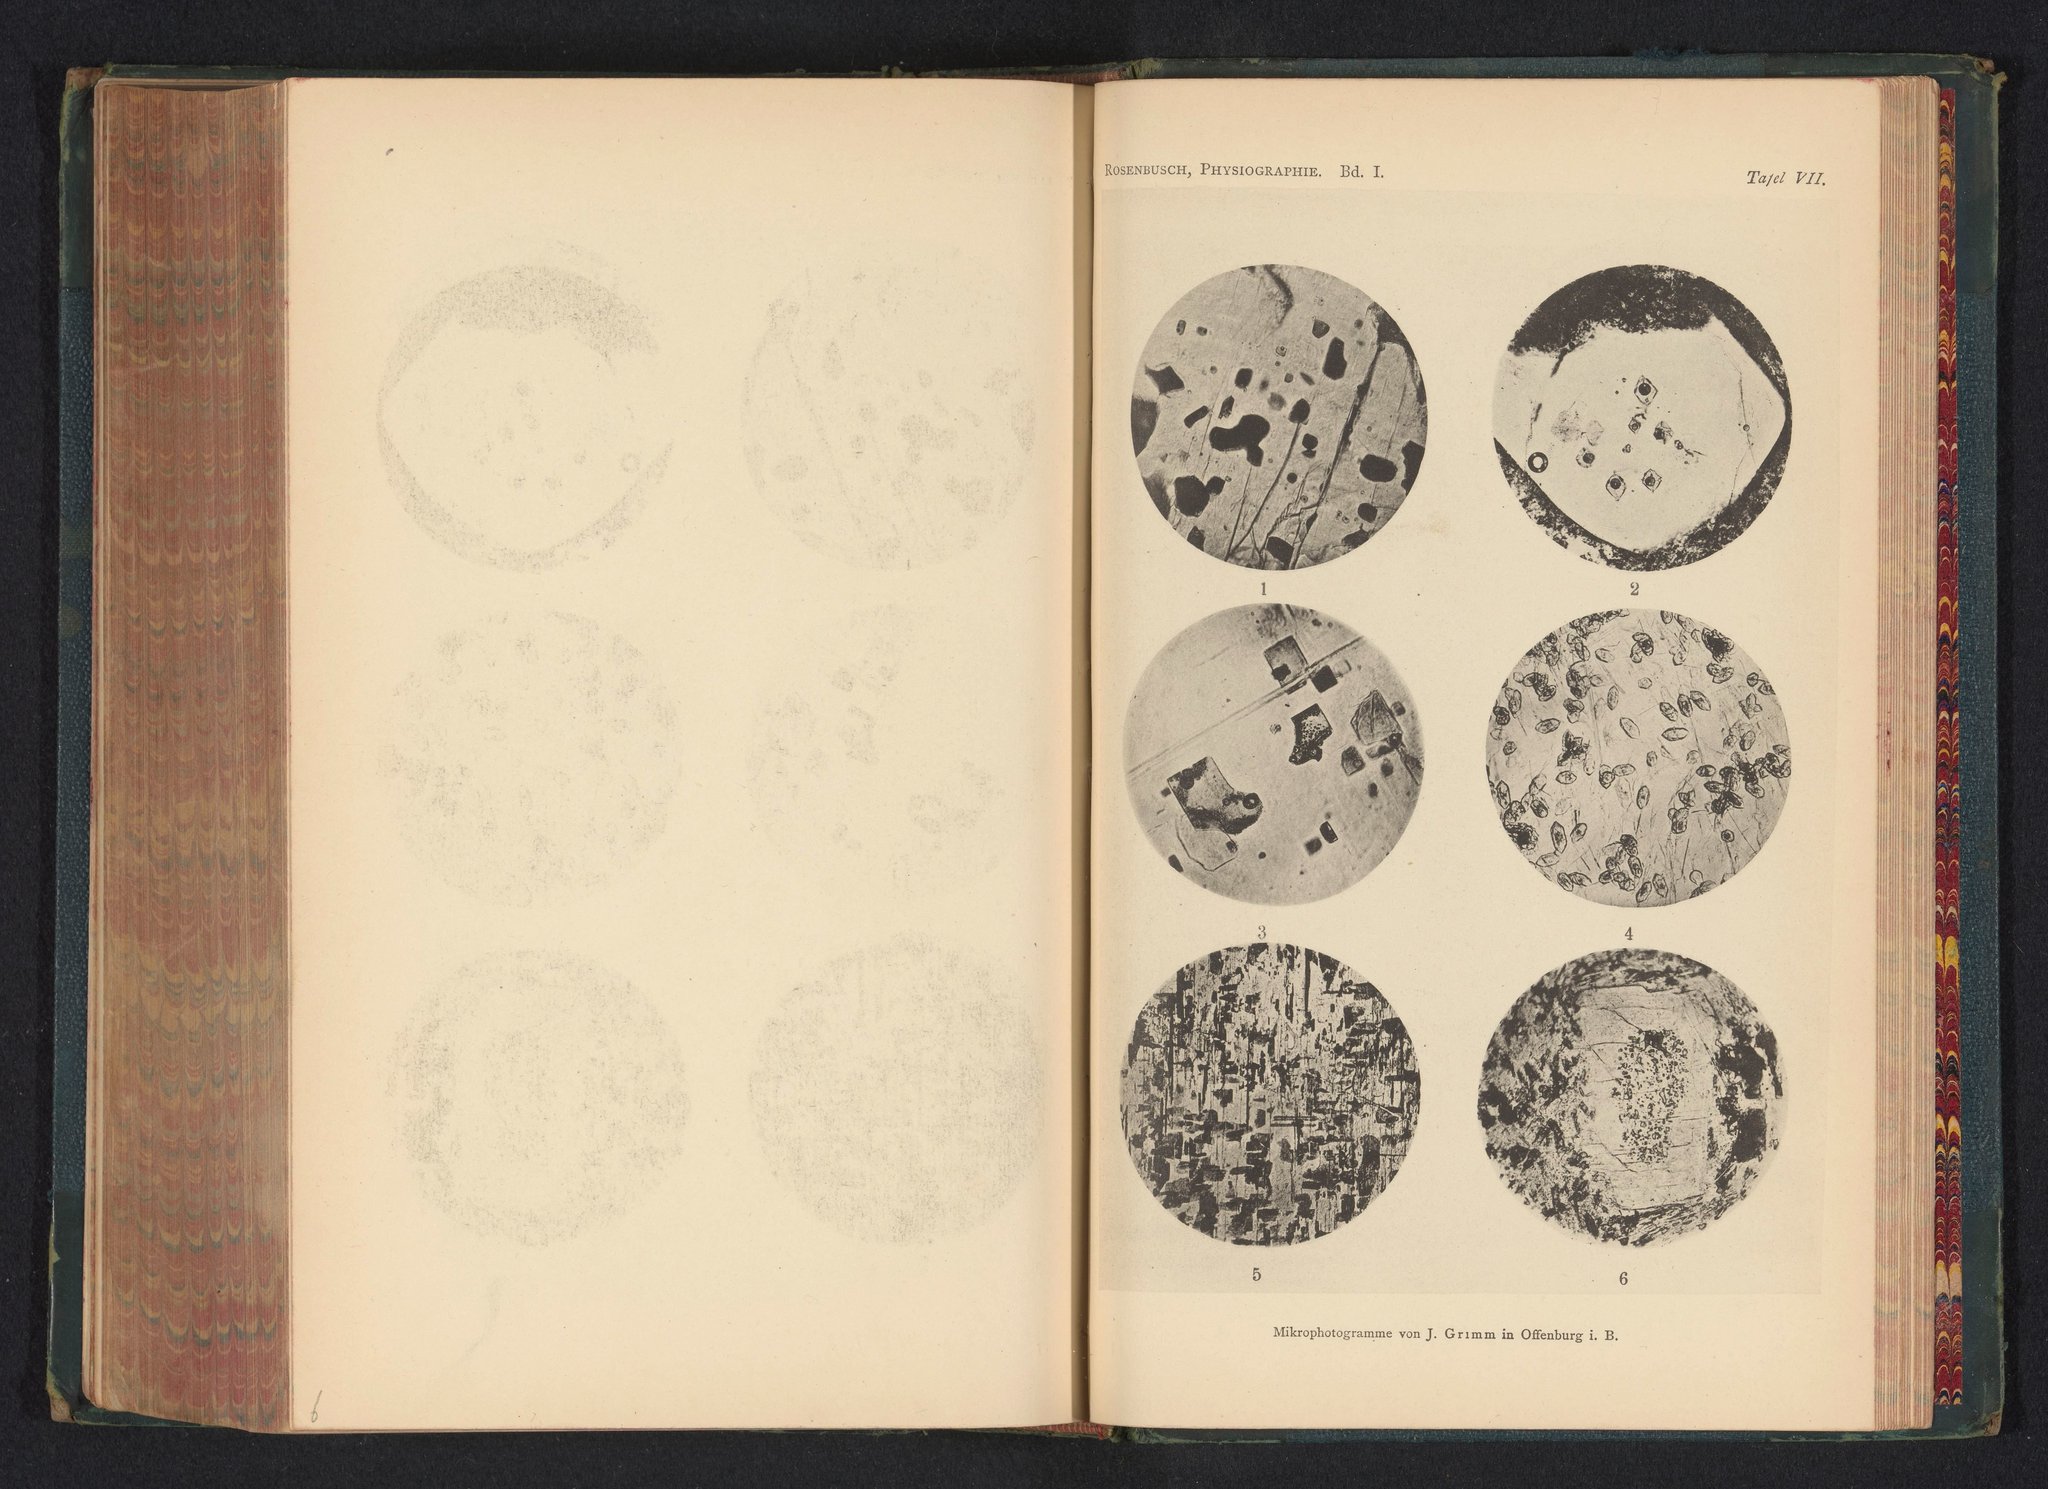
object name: page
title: Zes microscopische vergrotingen van mineralen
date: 1880-1885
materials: paper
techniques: photograph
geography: greifswald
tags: minerals and metals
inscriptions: number: ‘1 (...) 6’, number: ‘Tafel VII’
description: Afbeelding 1 is labradoriet, 2 is kwarts, 3 is oligoklaas, 4 is heulandiet, 5 is hyperstheen en 6 is veldspaat en trachiet.